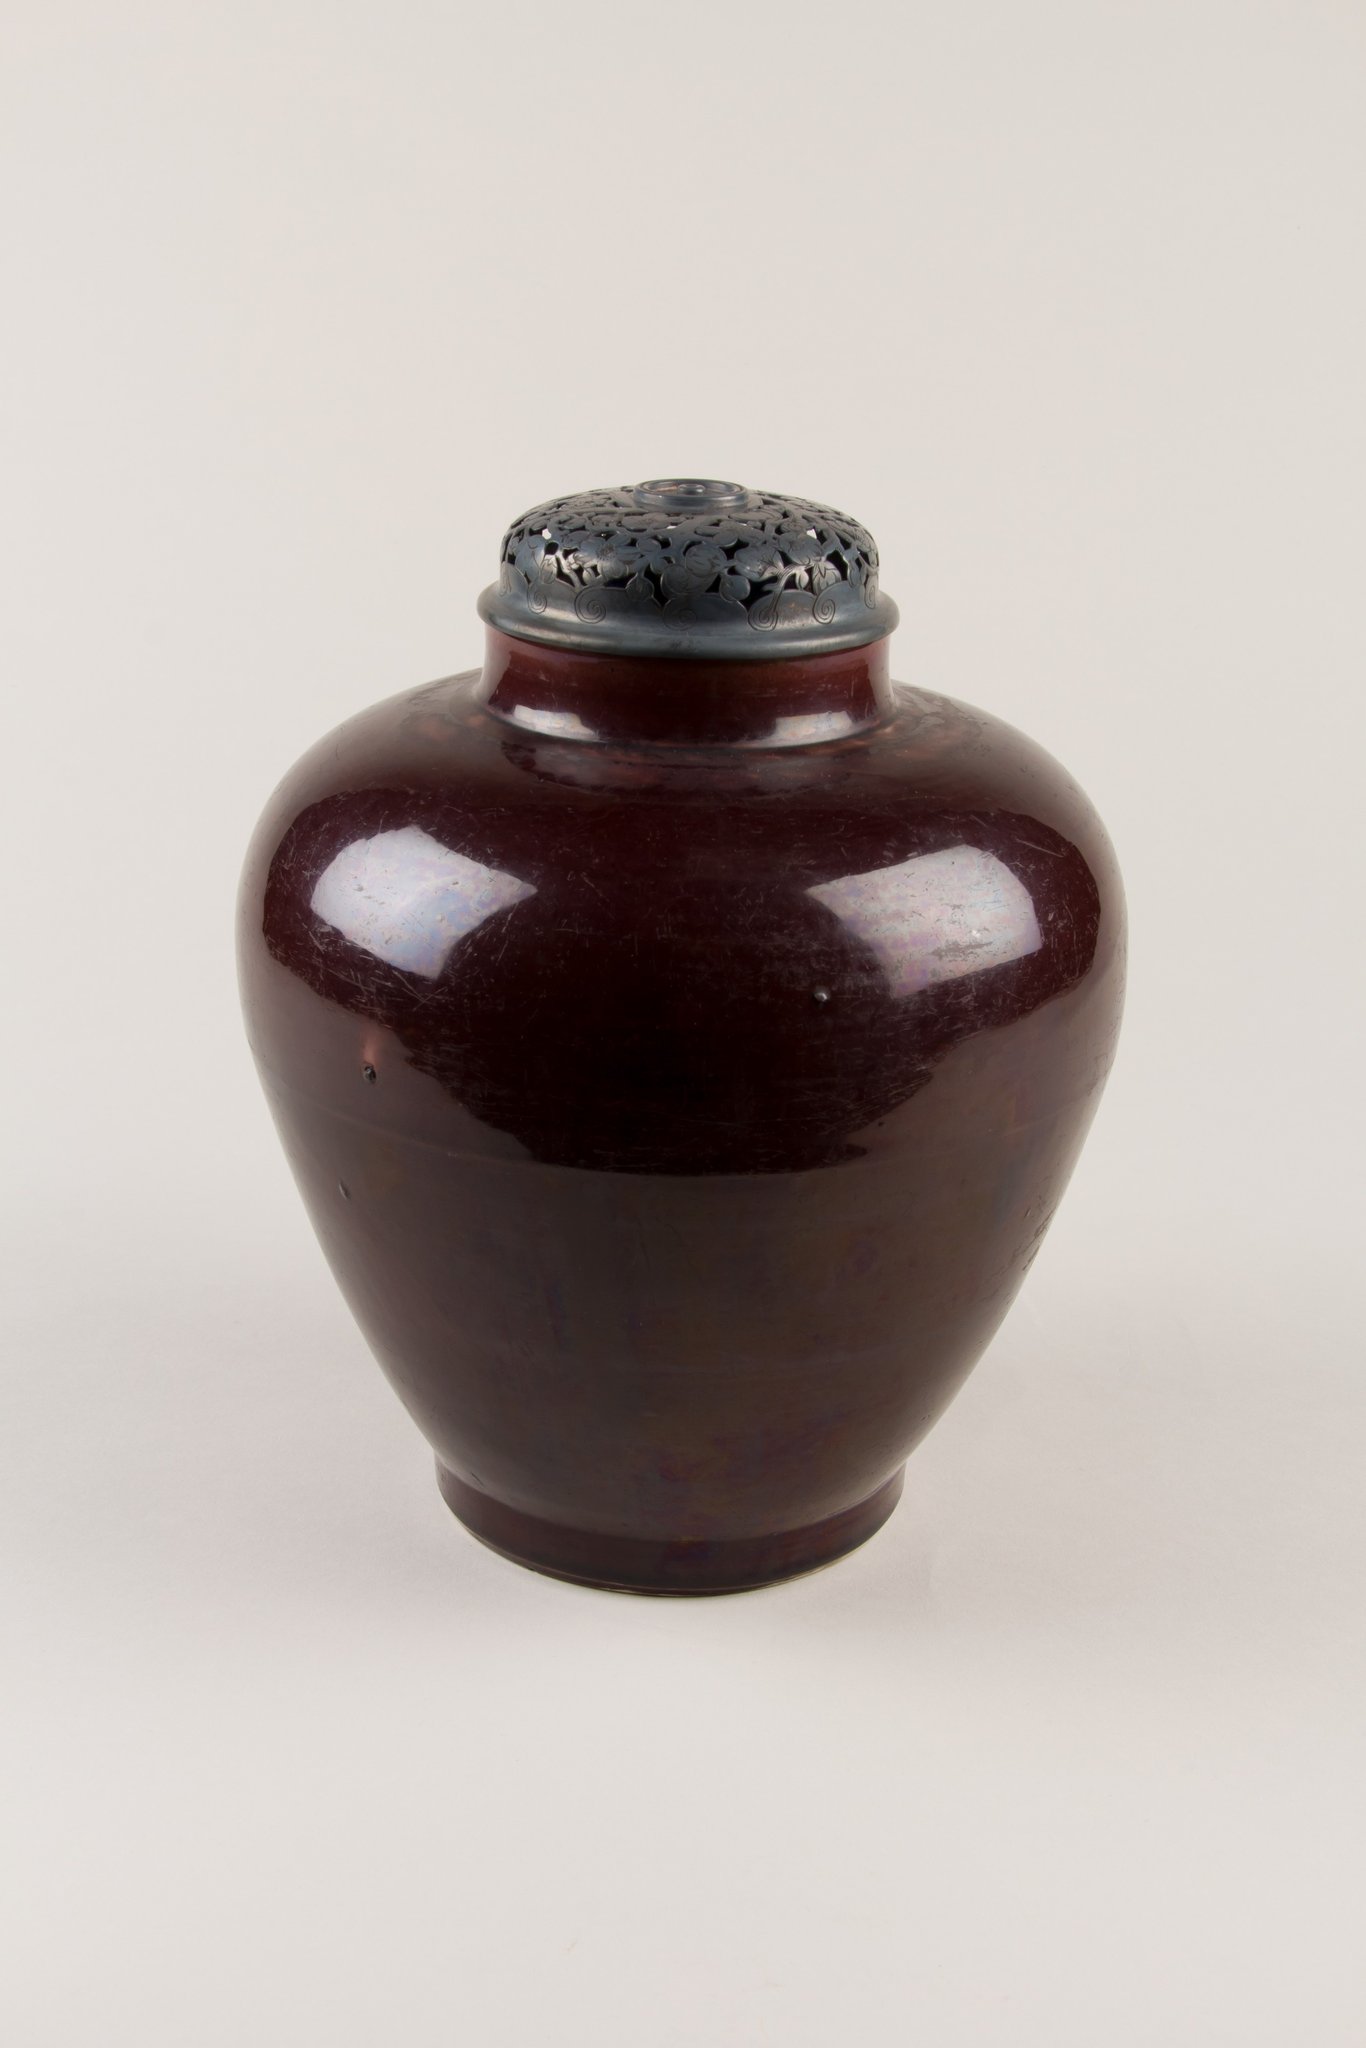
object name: jar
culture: chinese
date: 1801-1900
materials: glaze, porcelain